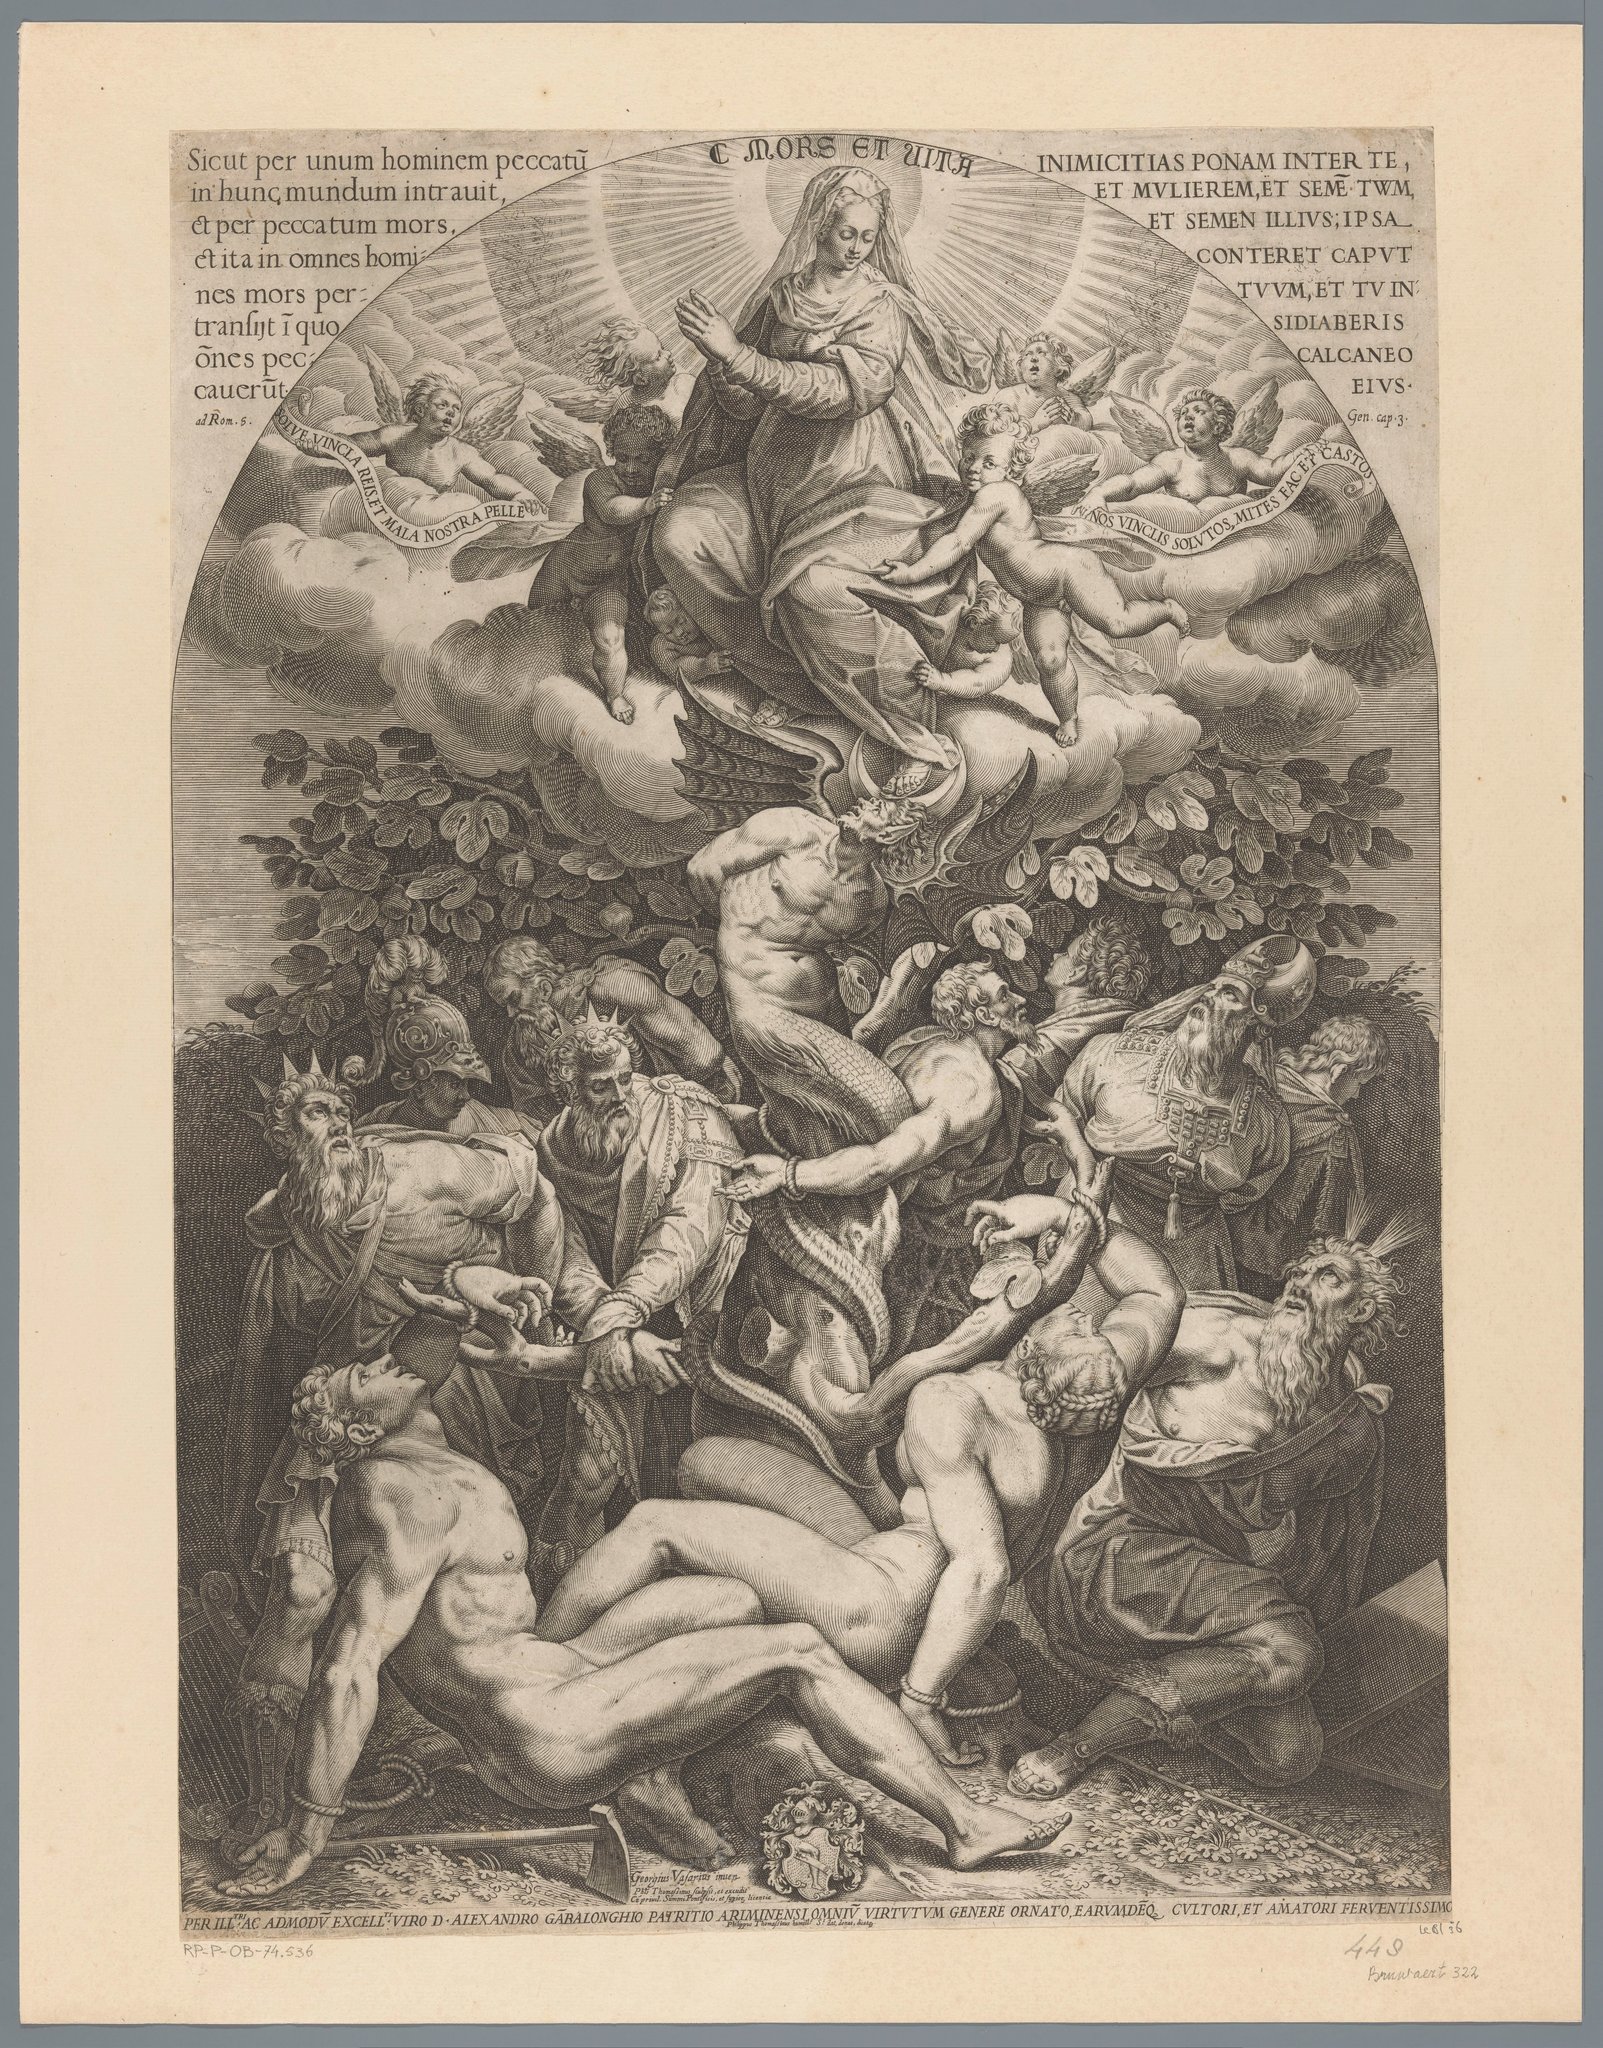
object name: print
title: Allegorie op de Onbevlekte Ontvangenis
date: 1612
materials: paper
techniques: engraving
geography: italy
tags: 'immaculata', 'purisima': mary, usually standing on a crescent moon, descending from heaven, exempt from original sin (sometimes trampling serpent)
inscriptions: collector's mark: Lugt 240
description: Onderaan zijn Adam en Eva vastgebonden aan de boom van de kennis van goed en kwaad met daarin de slang. Naast hen bevinden zich Mozes, koningen, priesters, een soldaat en overige figuren. Bovenaan de boom zweeft Maria met engelen op een wolk. Met haar linkervoet staat zij op een halve maan en vertrapt zij de slang in de boom.